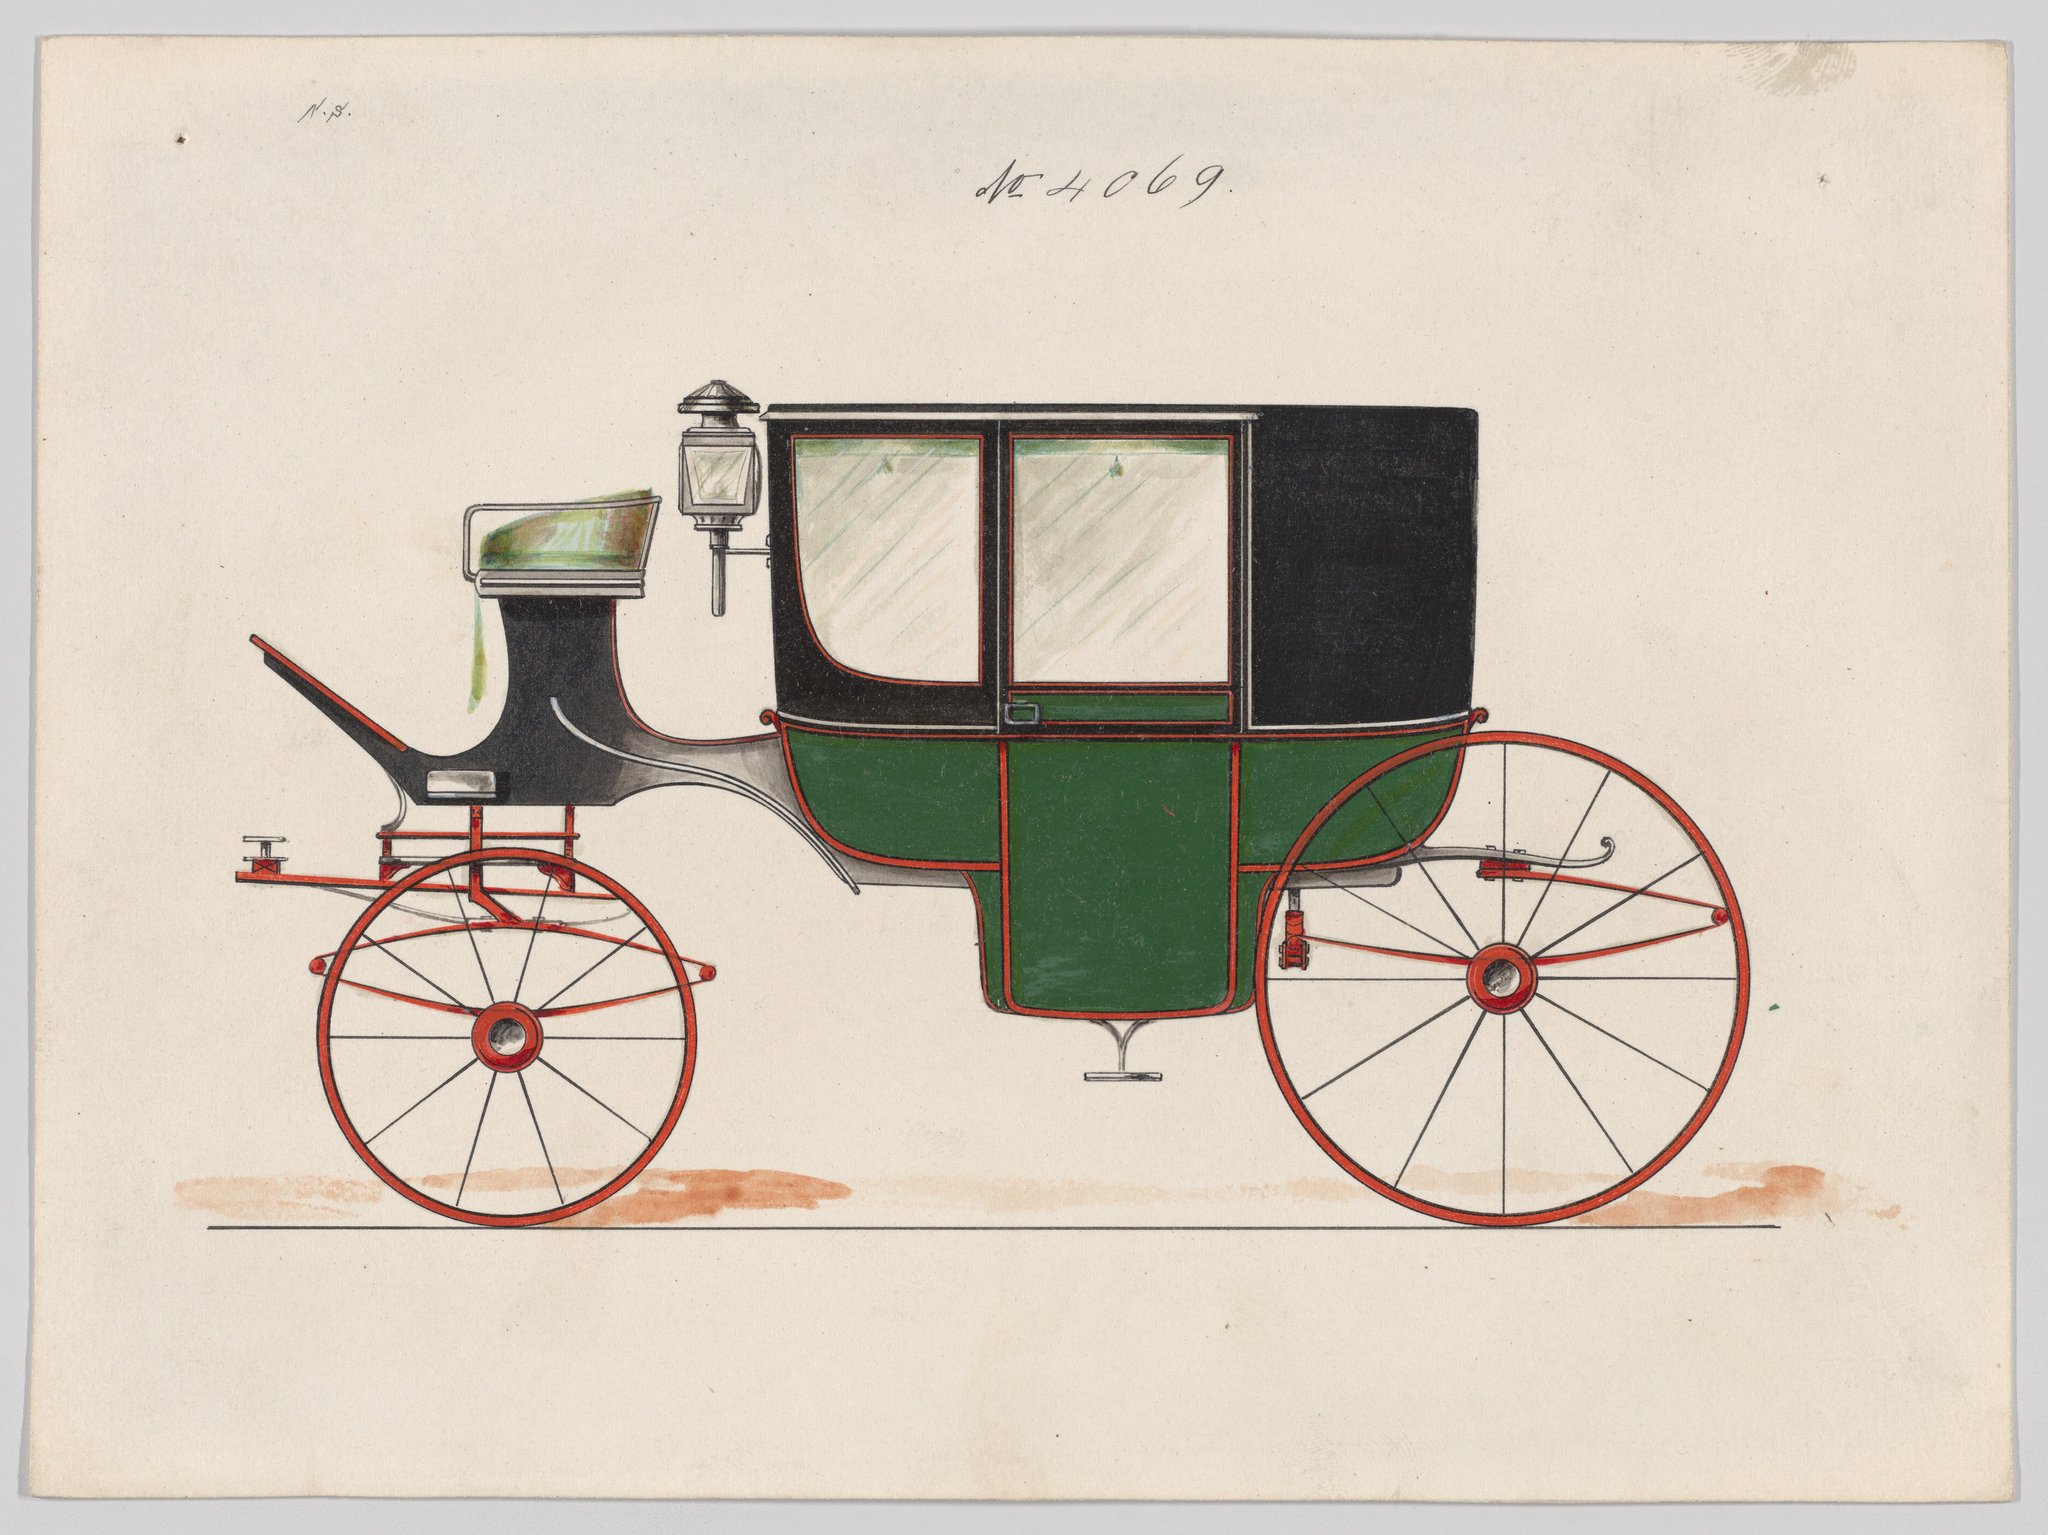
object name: drawing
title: Coach #4069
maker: brewster & co.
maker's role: manufacturer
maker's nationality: american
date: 1890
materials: gouache, gum arabic, ink, watercolor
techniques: pen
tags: carriages